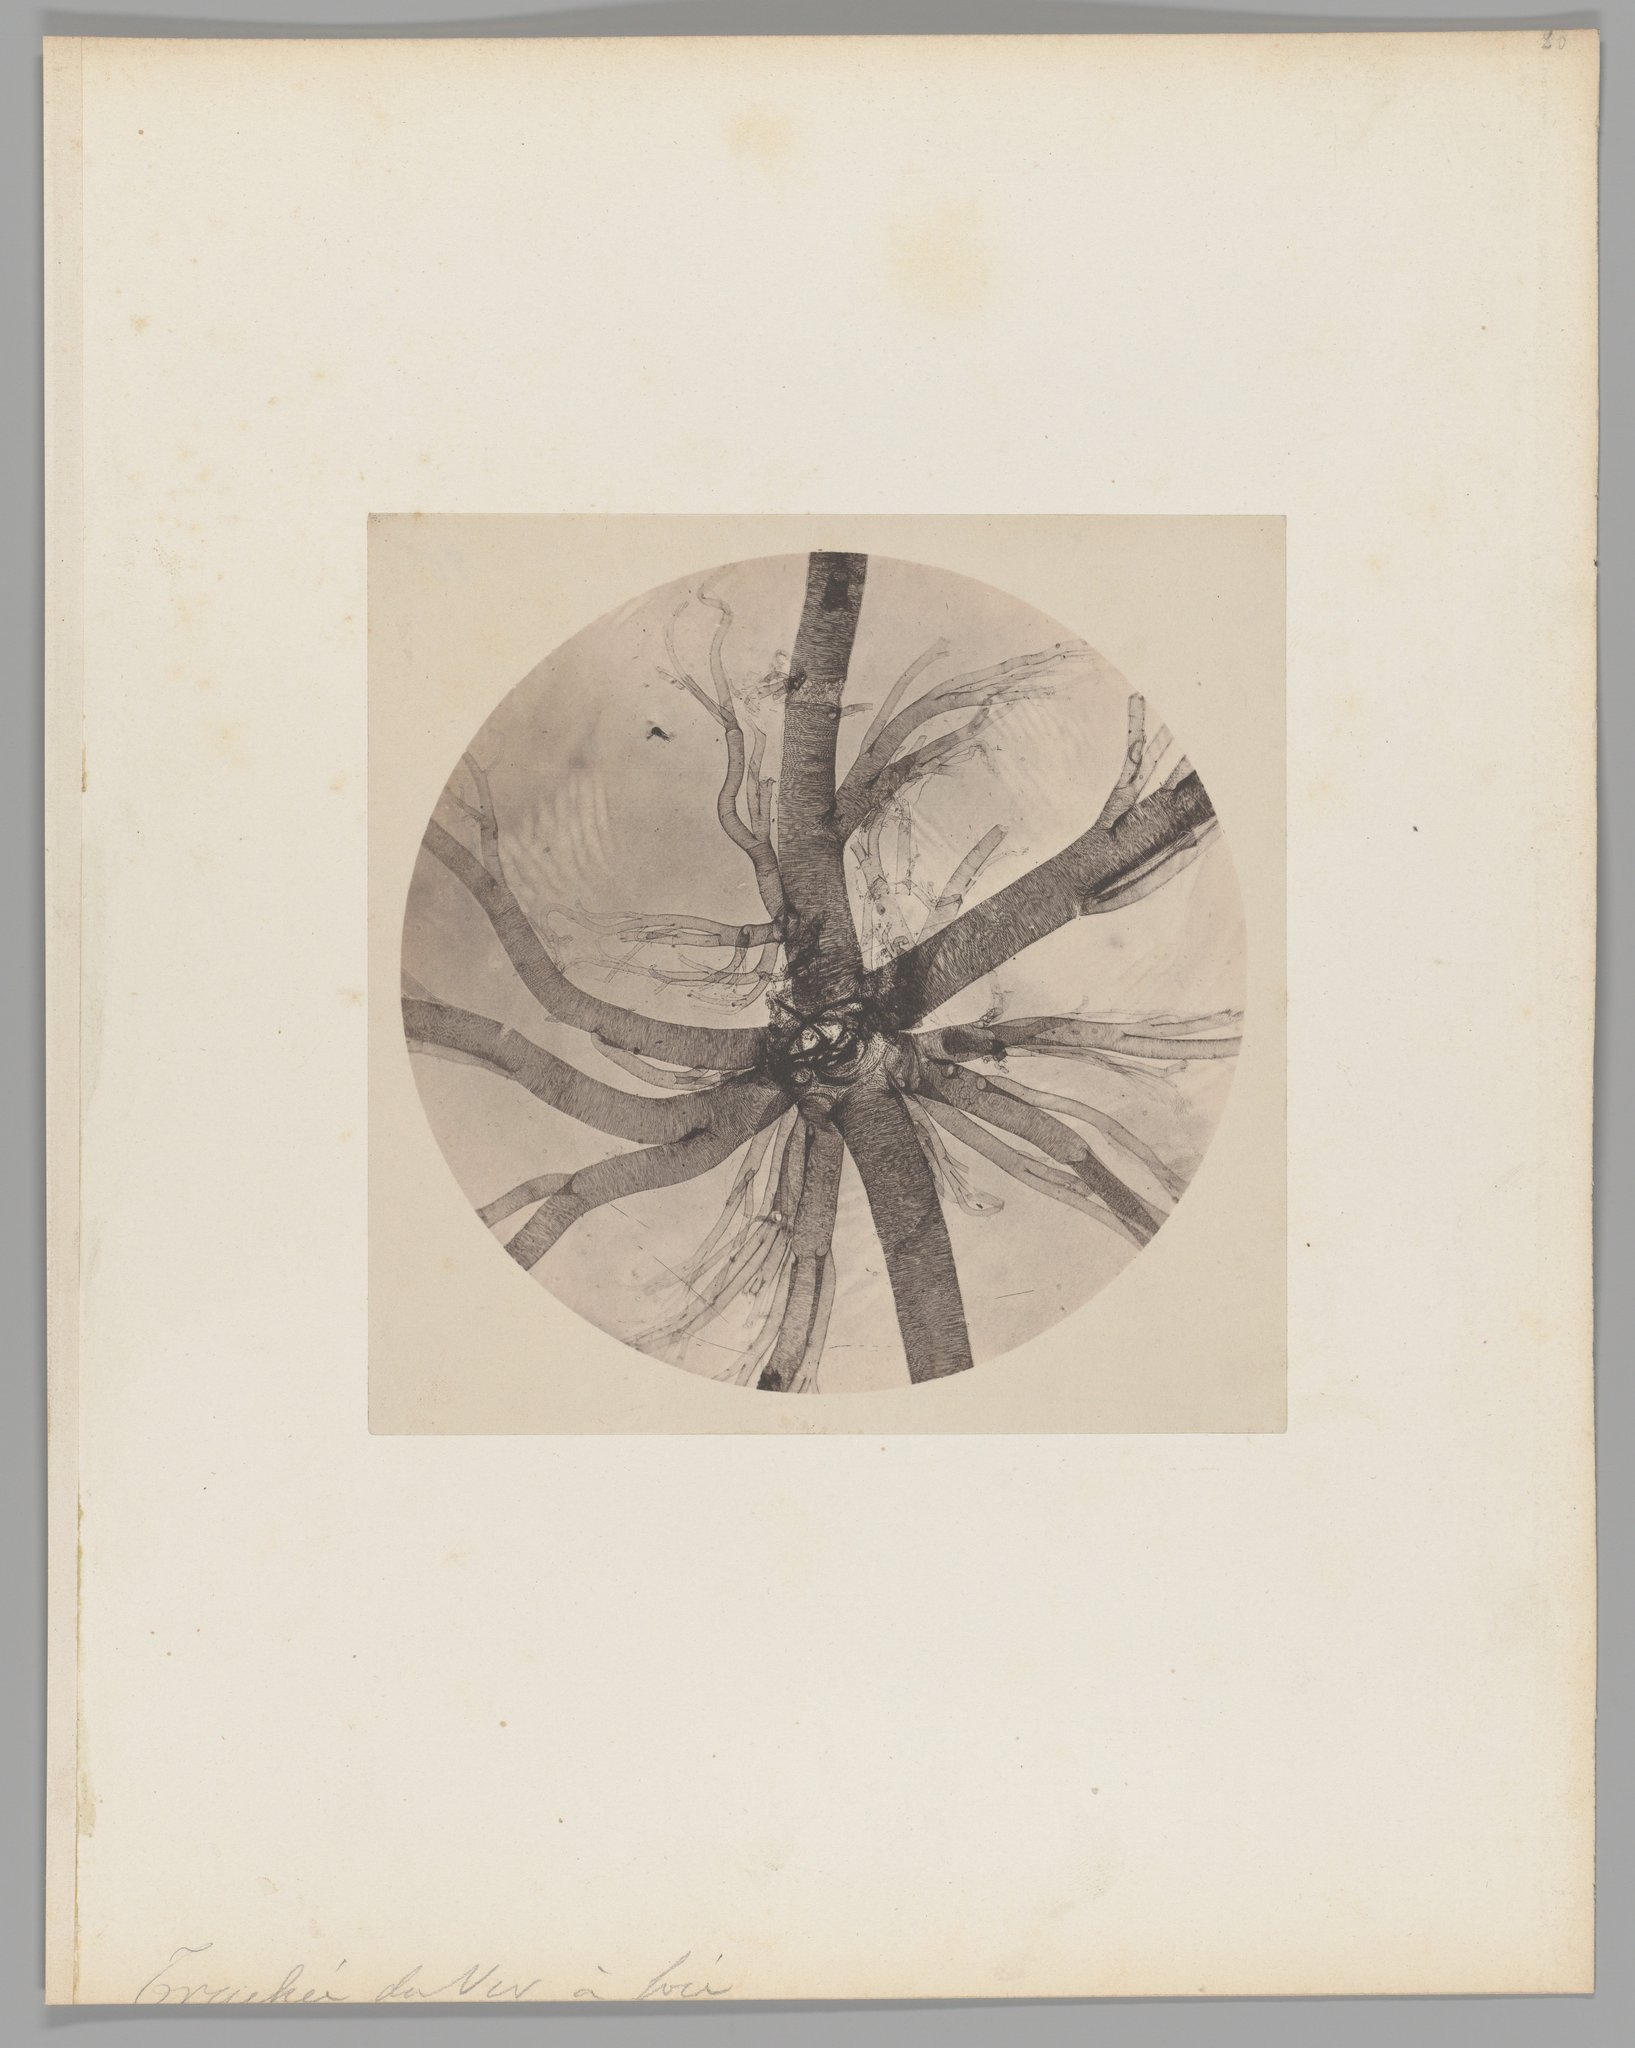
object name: photograph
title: [Untitled]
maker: auguste-adolphe bertsch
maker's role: artist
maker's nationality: french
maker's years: 1813-1871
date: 1853-1857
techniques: salted paper print